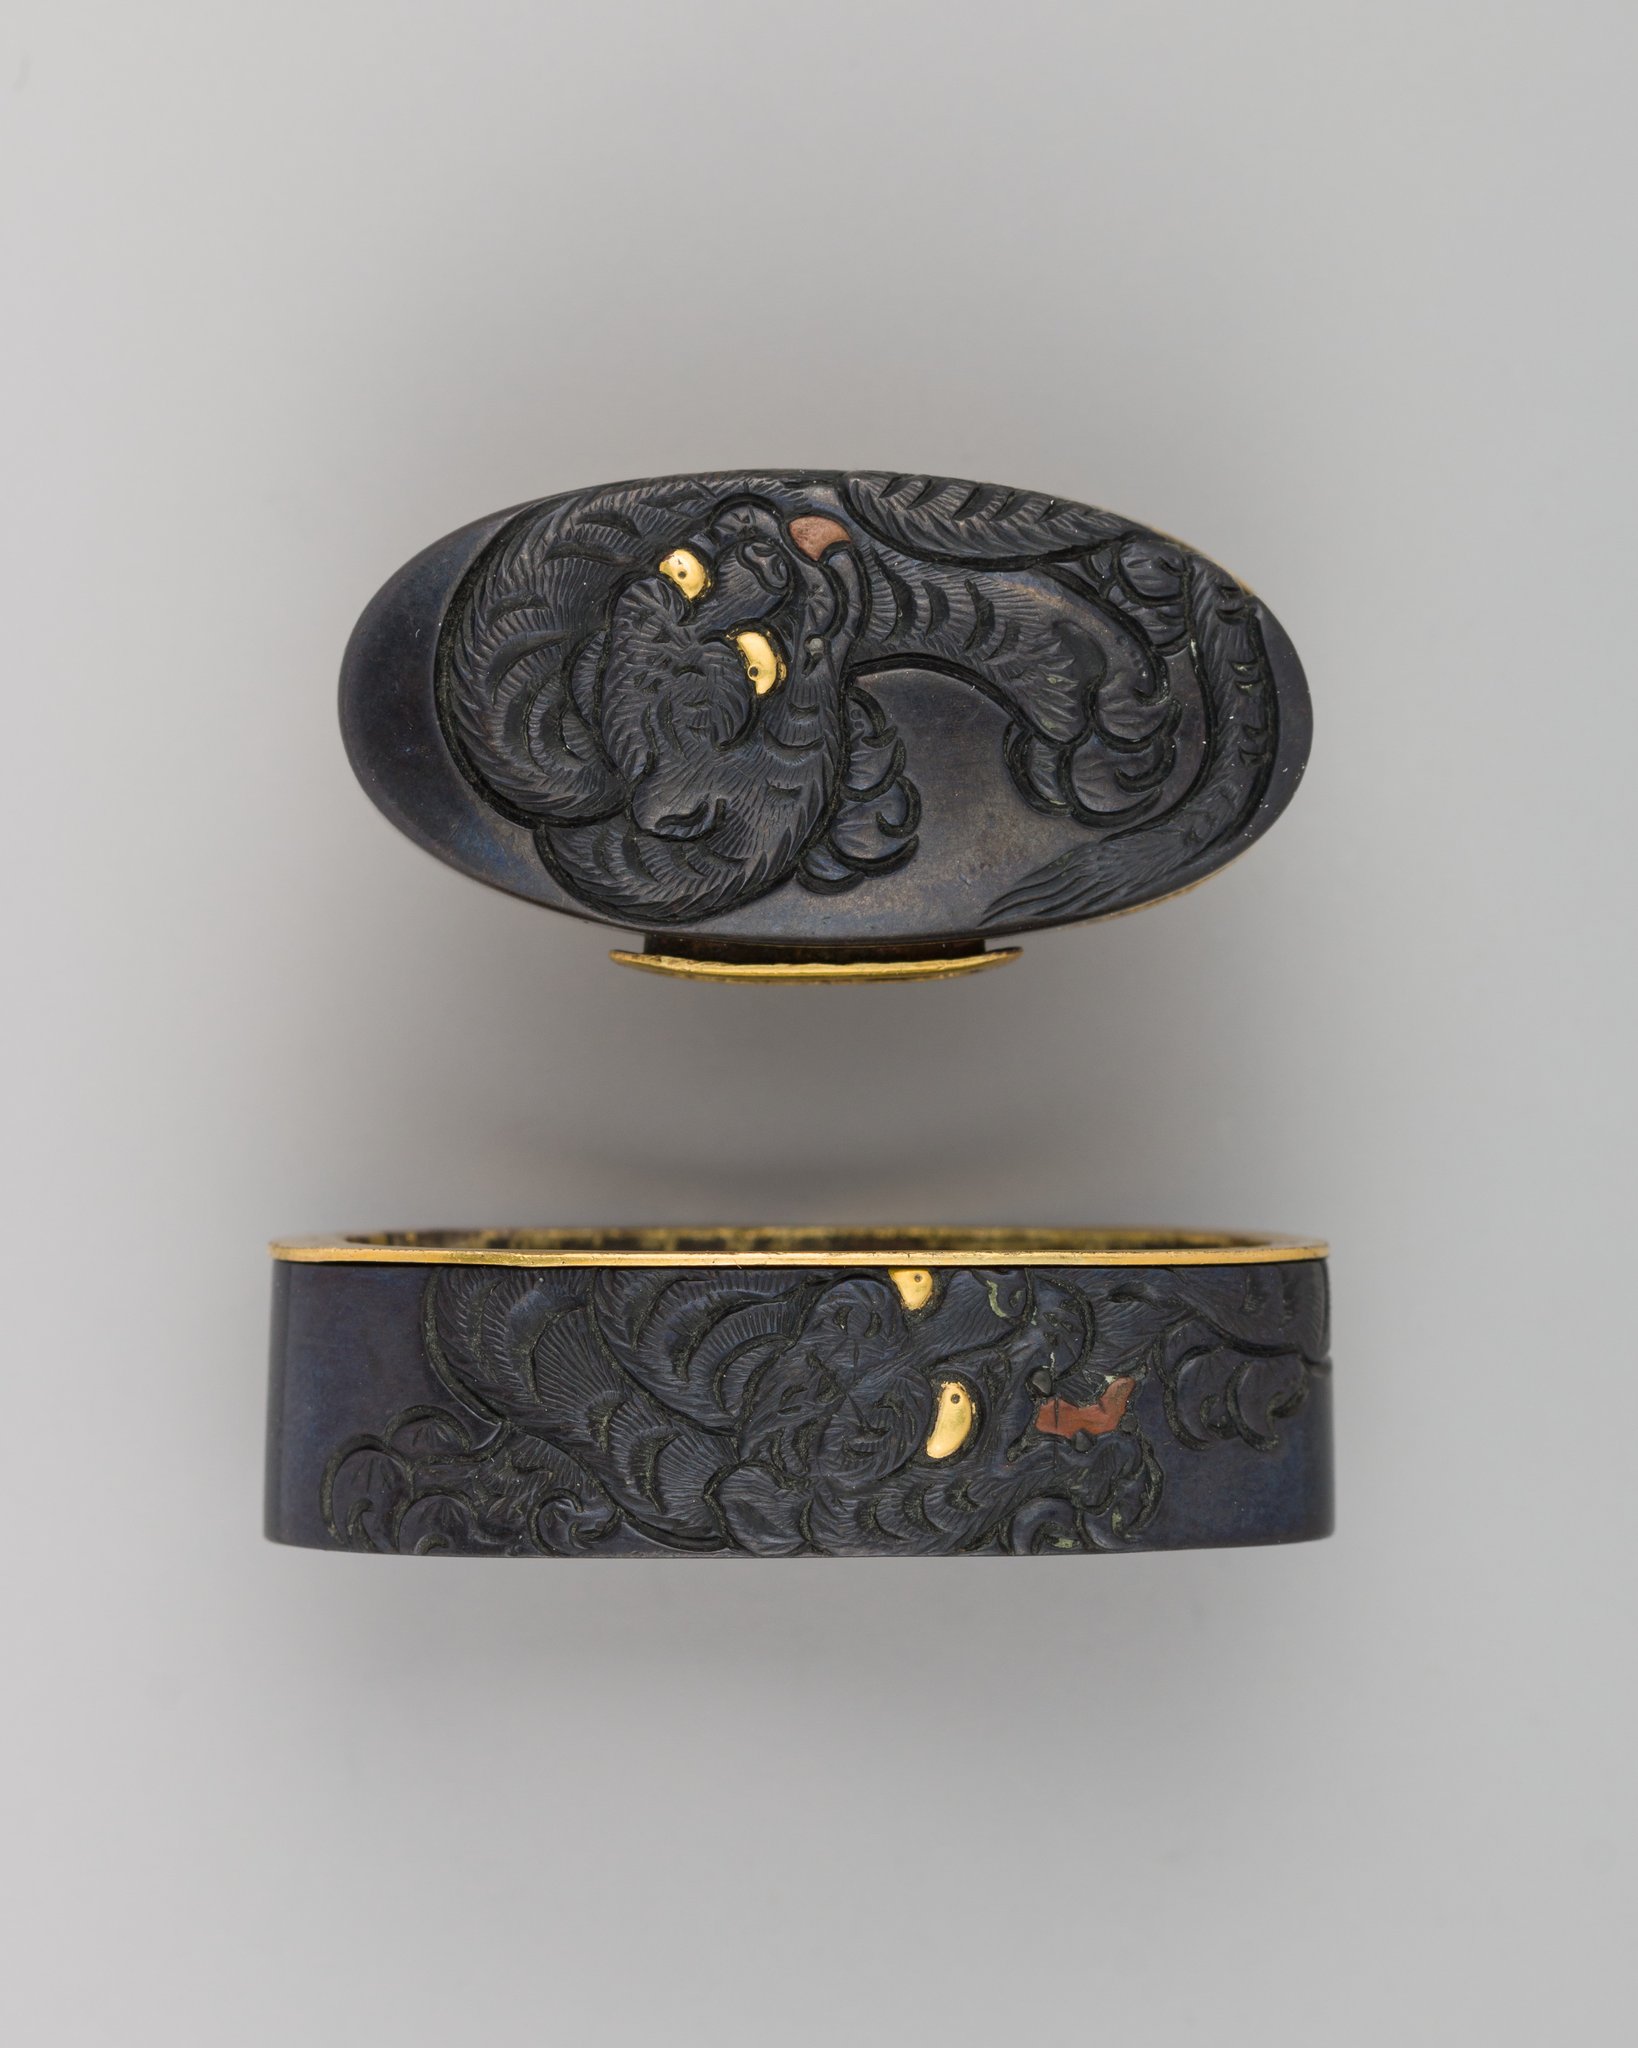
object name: sword hilt collar and pommel fuchigashira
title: Sword-Hilt Collar and Pommel (Fuchigashira)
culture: japanese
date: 1767-1800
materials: copper, gold alloy, gold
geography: japan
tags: tigers